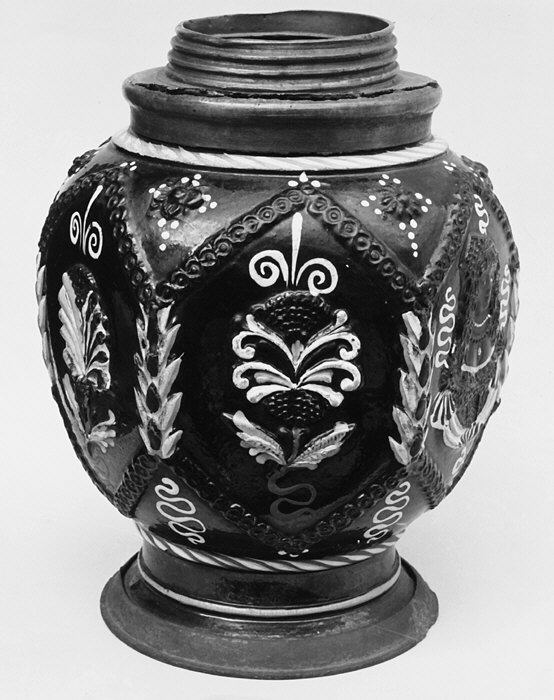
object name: jar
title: Screw-top jar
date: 1667-1700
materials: stoneware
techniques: salt glaze